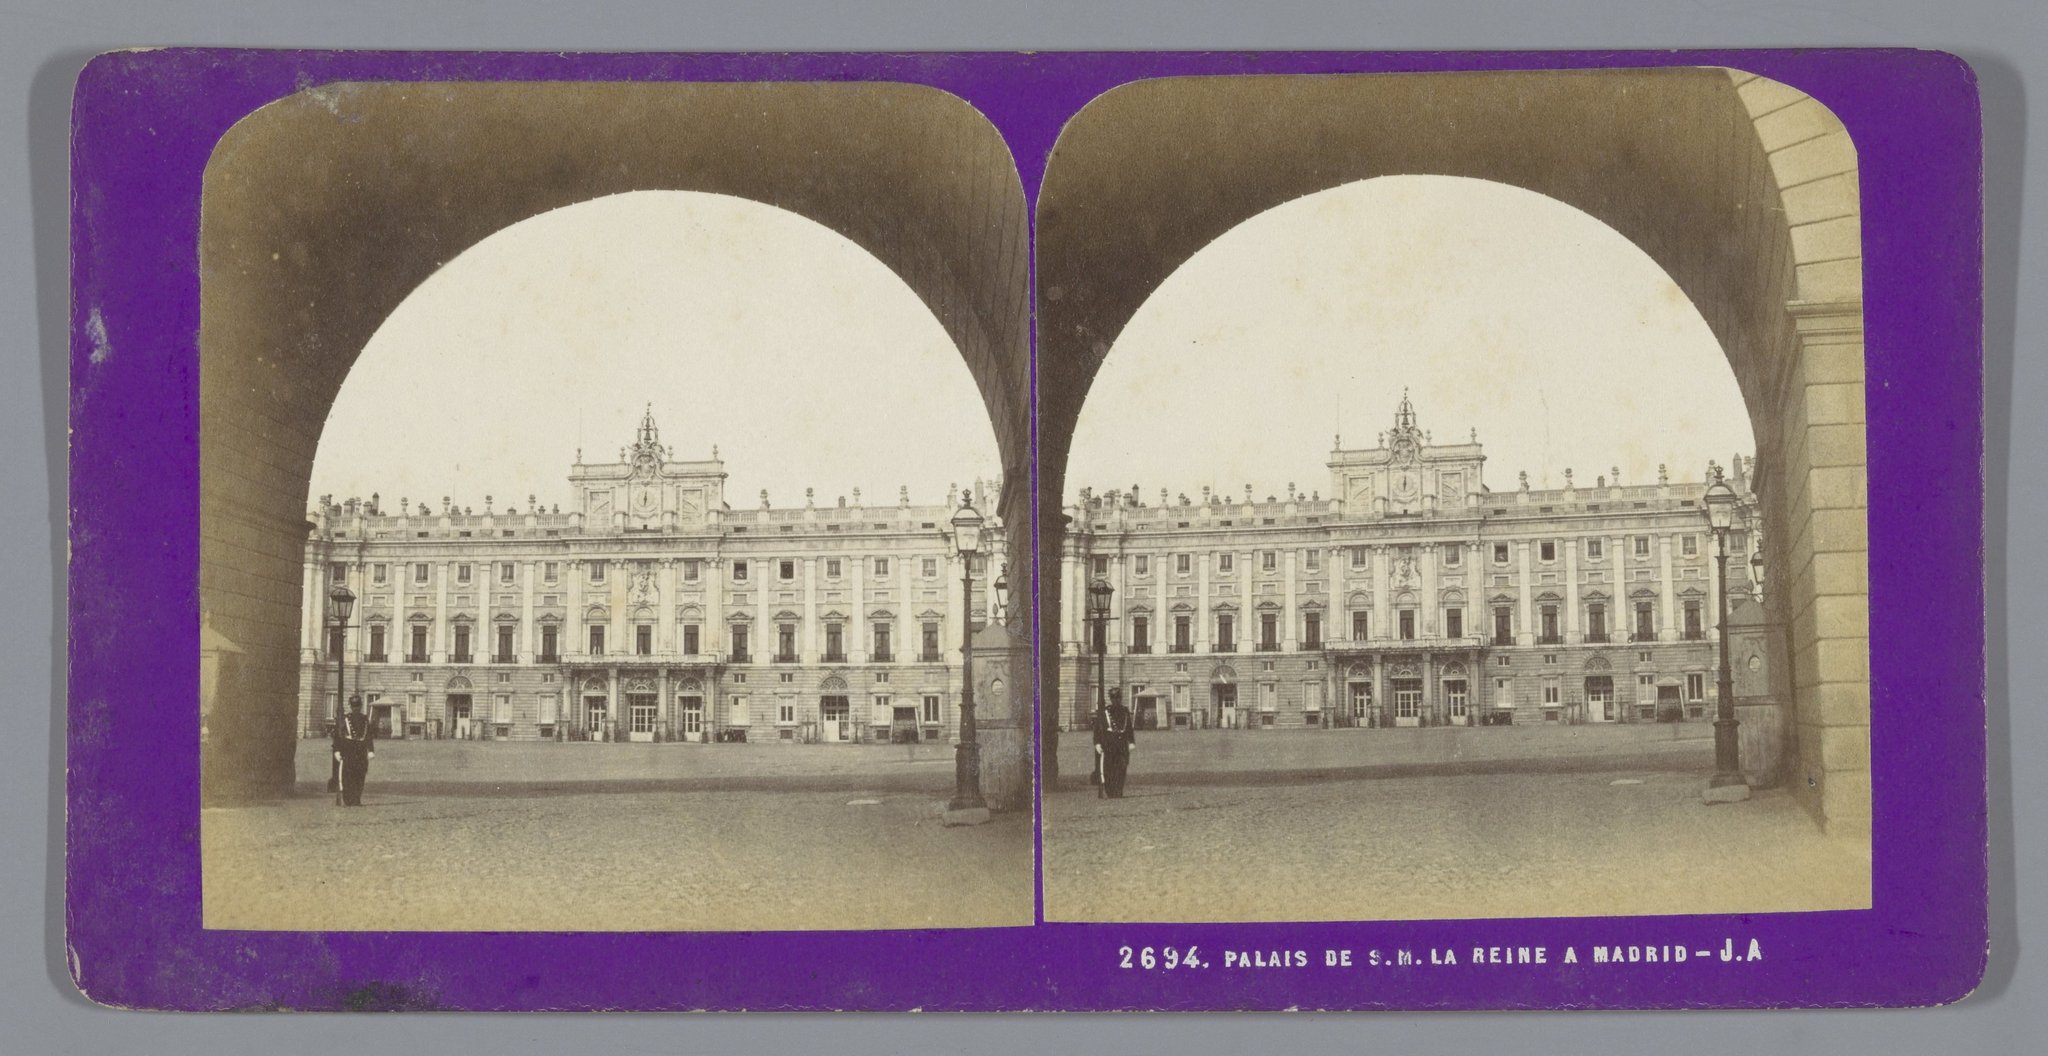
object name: stereograph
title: Gezicht op het Palacio Real te Madrid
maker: jean andrieu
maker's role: fotograaf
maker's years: 1816-1872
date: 1862-1876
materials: cardboard, photographic support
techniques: albumen print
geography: madrid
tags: palace, façade (of house or building)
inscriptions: number: ‘2694.’